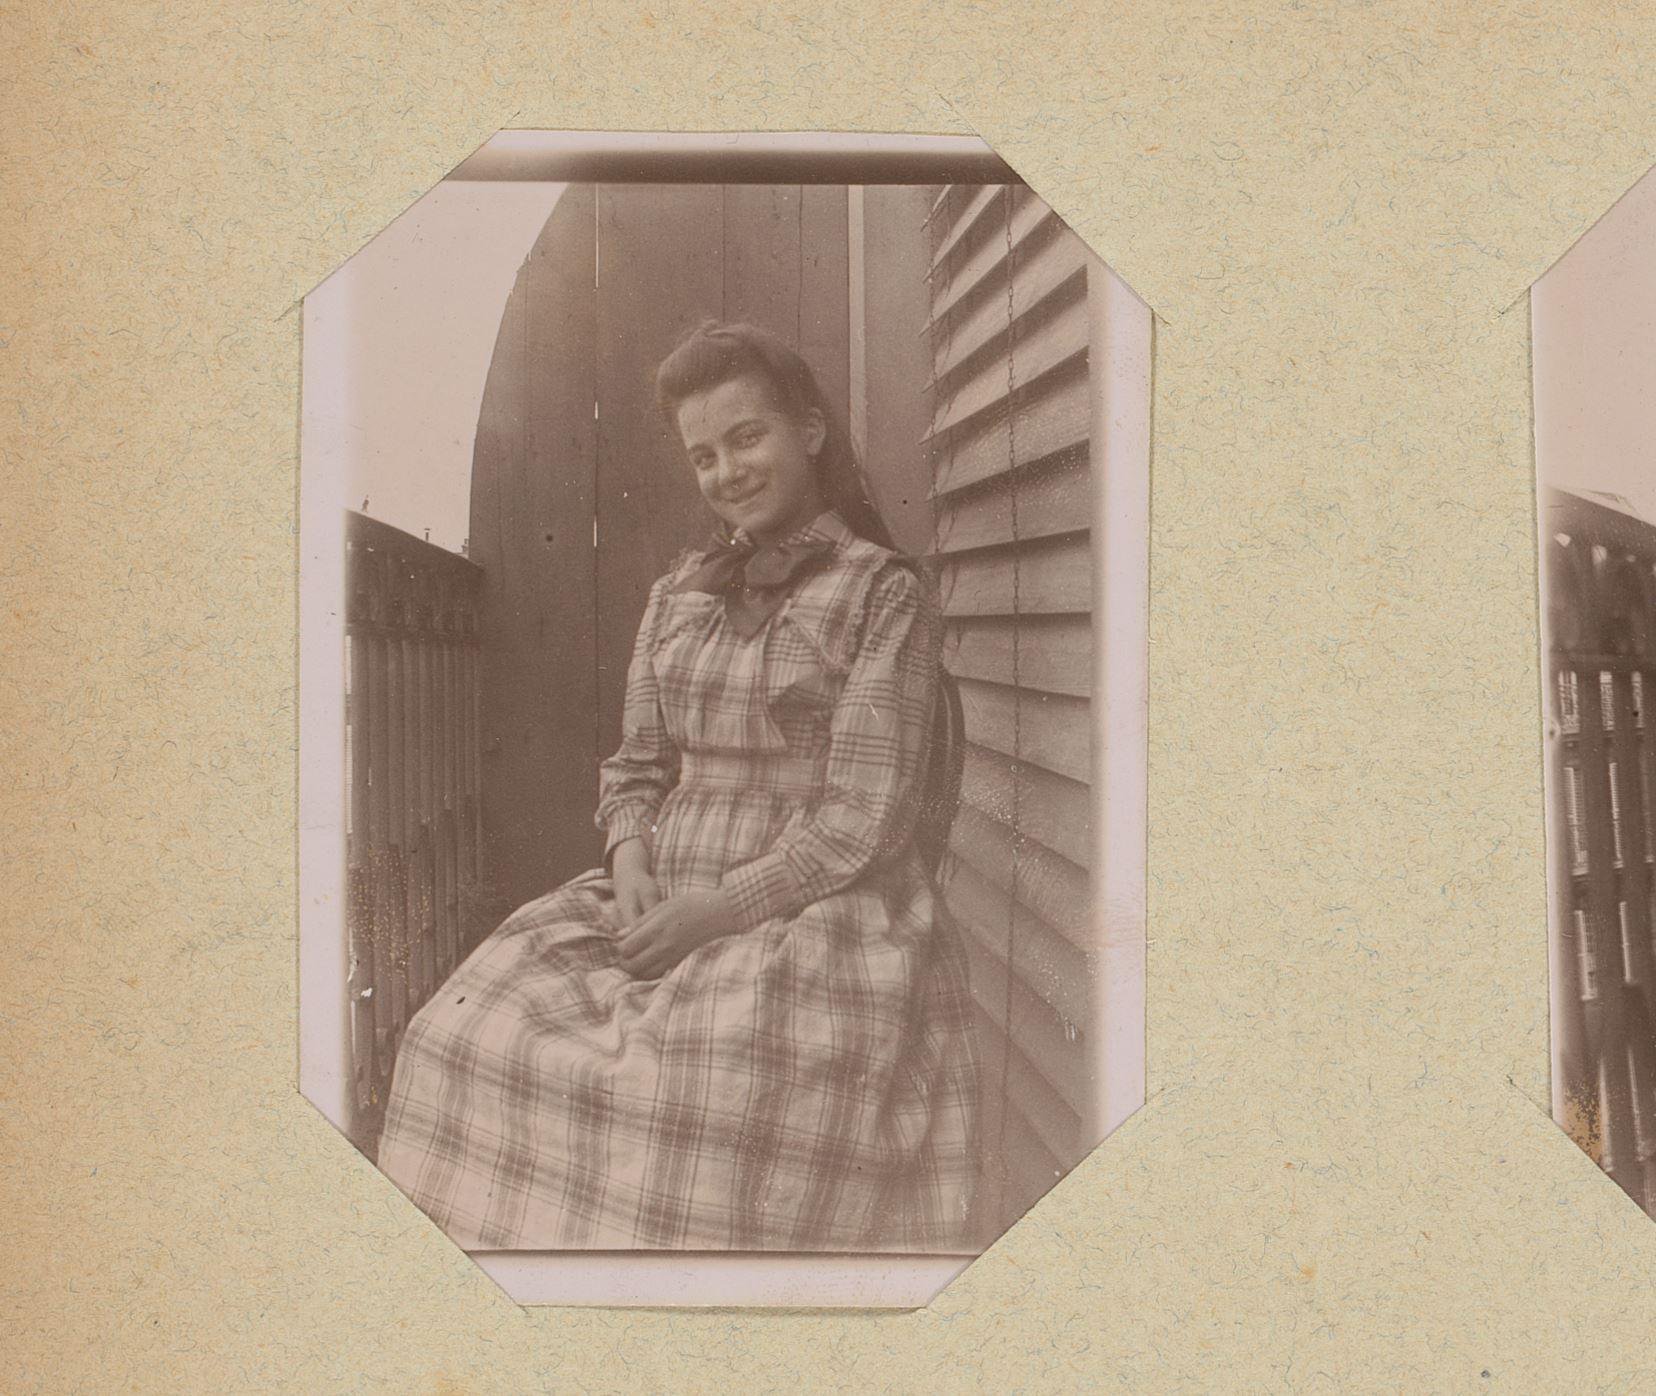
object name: album leaf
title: Portret van een meisje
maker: Anonymous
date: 1897-1900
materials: paper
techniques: gelatin silver print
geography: france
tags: historical persons, girl (child between toddler and youth), france